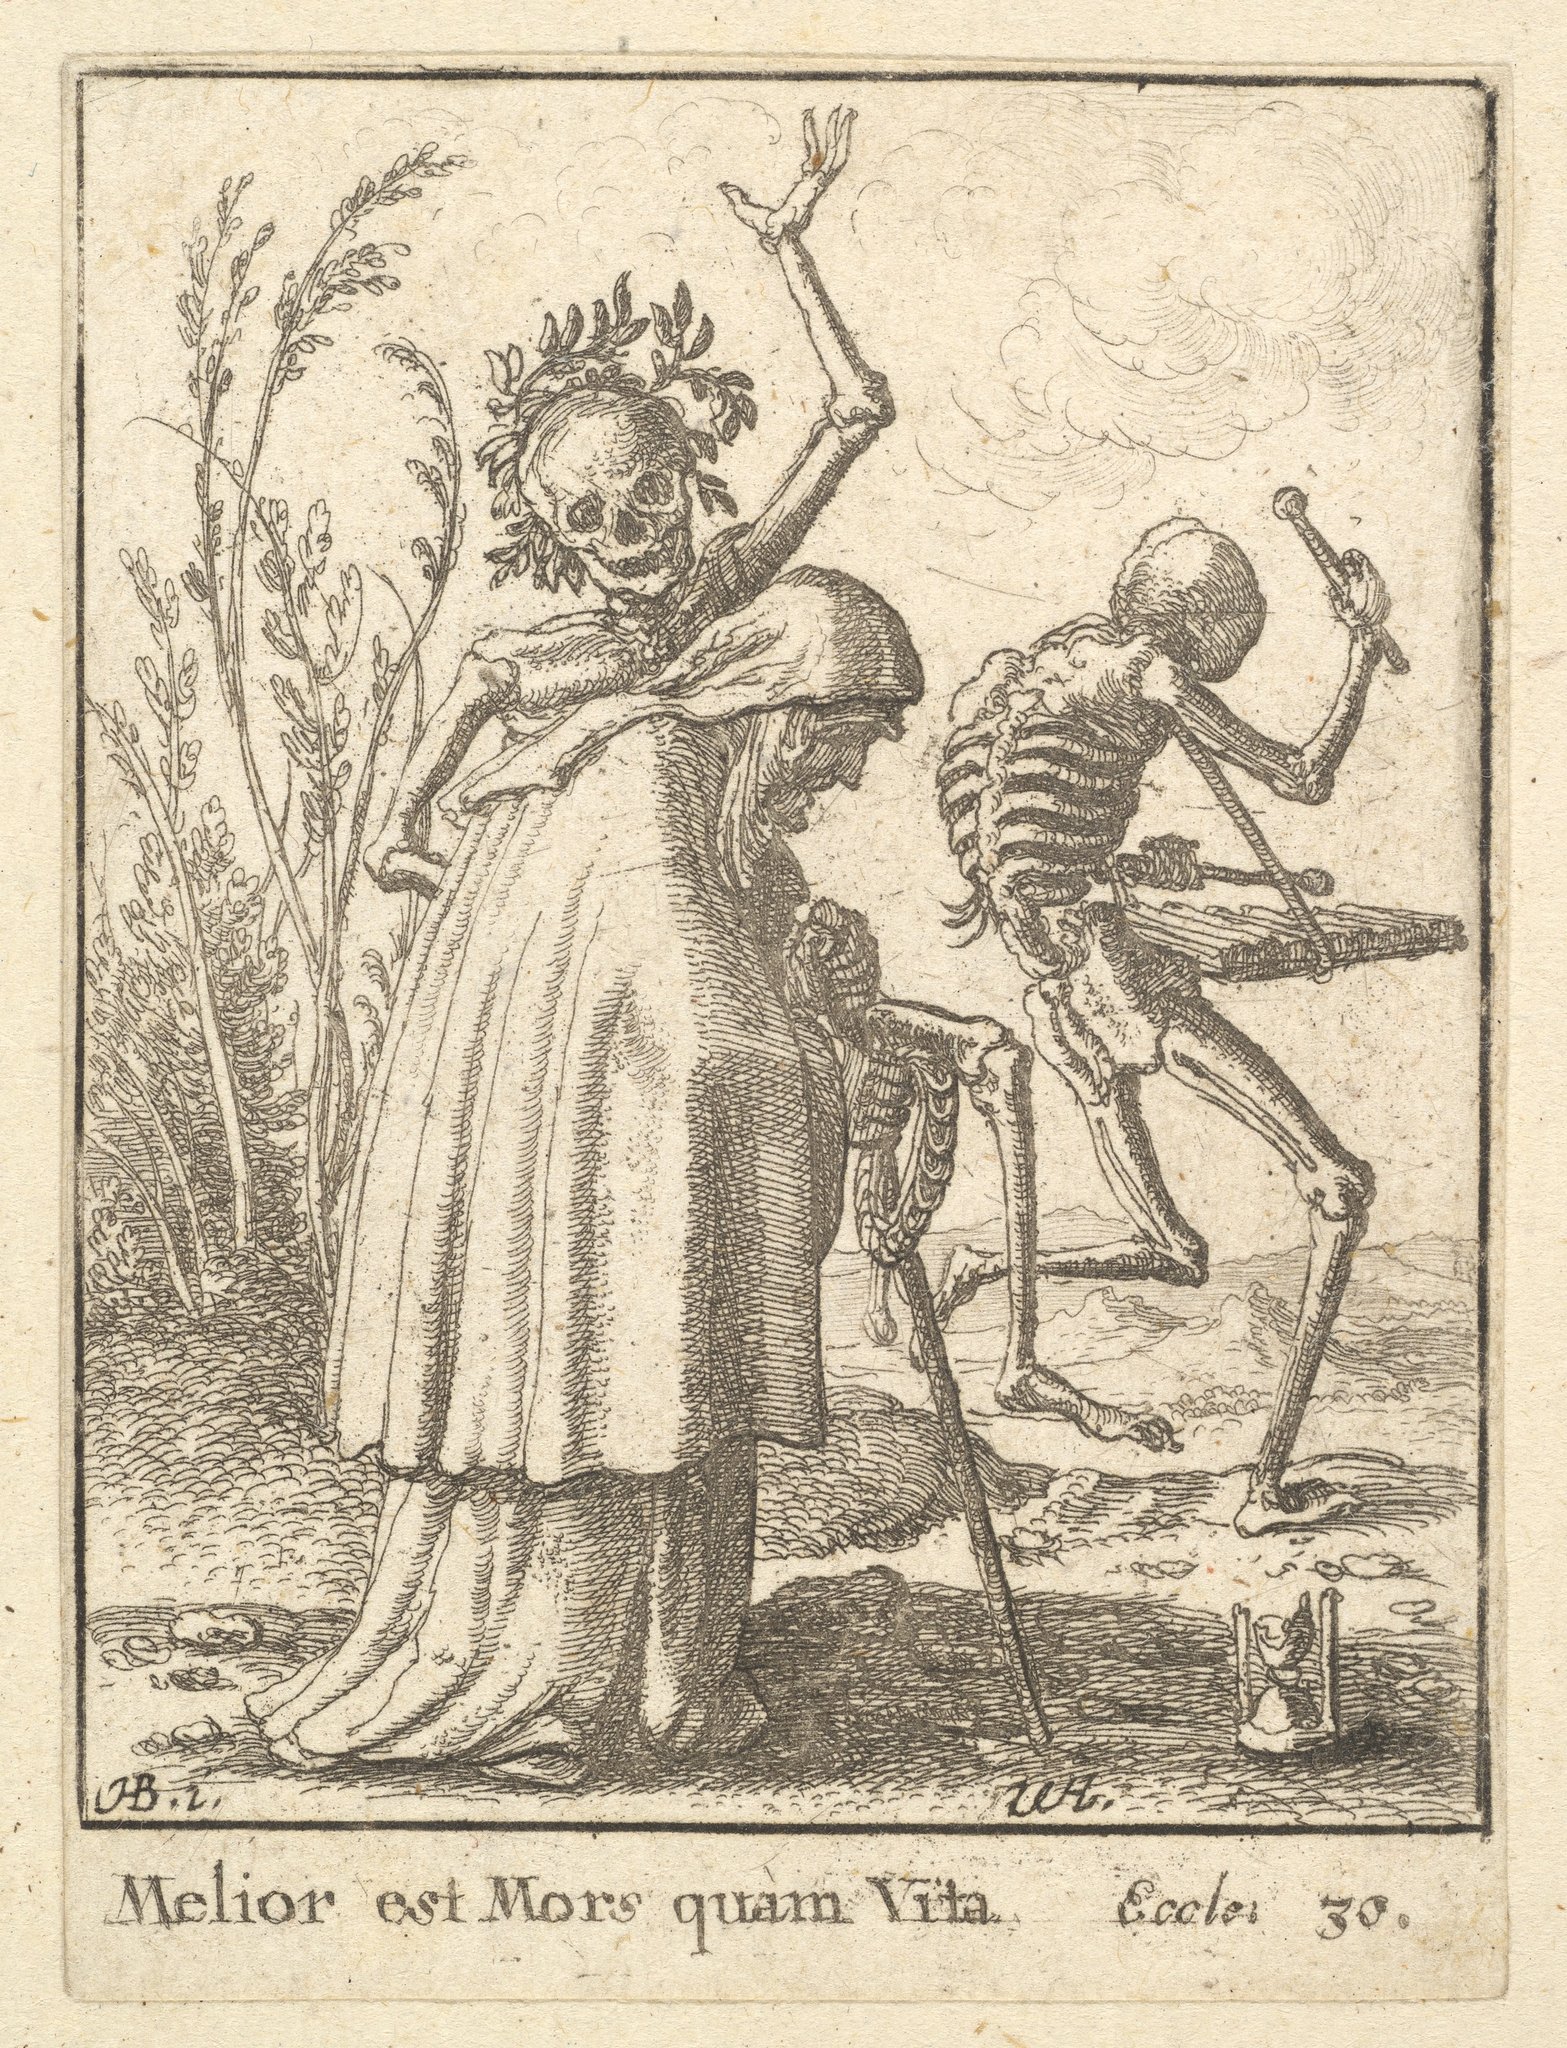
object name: print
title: Old woman, from the Dance of Death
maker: wenceslaus hollar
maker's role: artist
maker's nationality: bohemian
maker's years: 1607-1677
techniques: etching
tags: skeletons,women